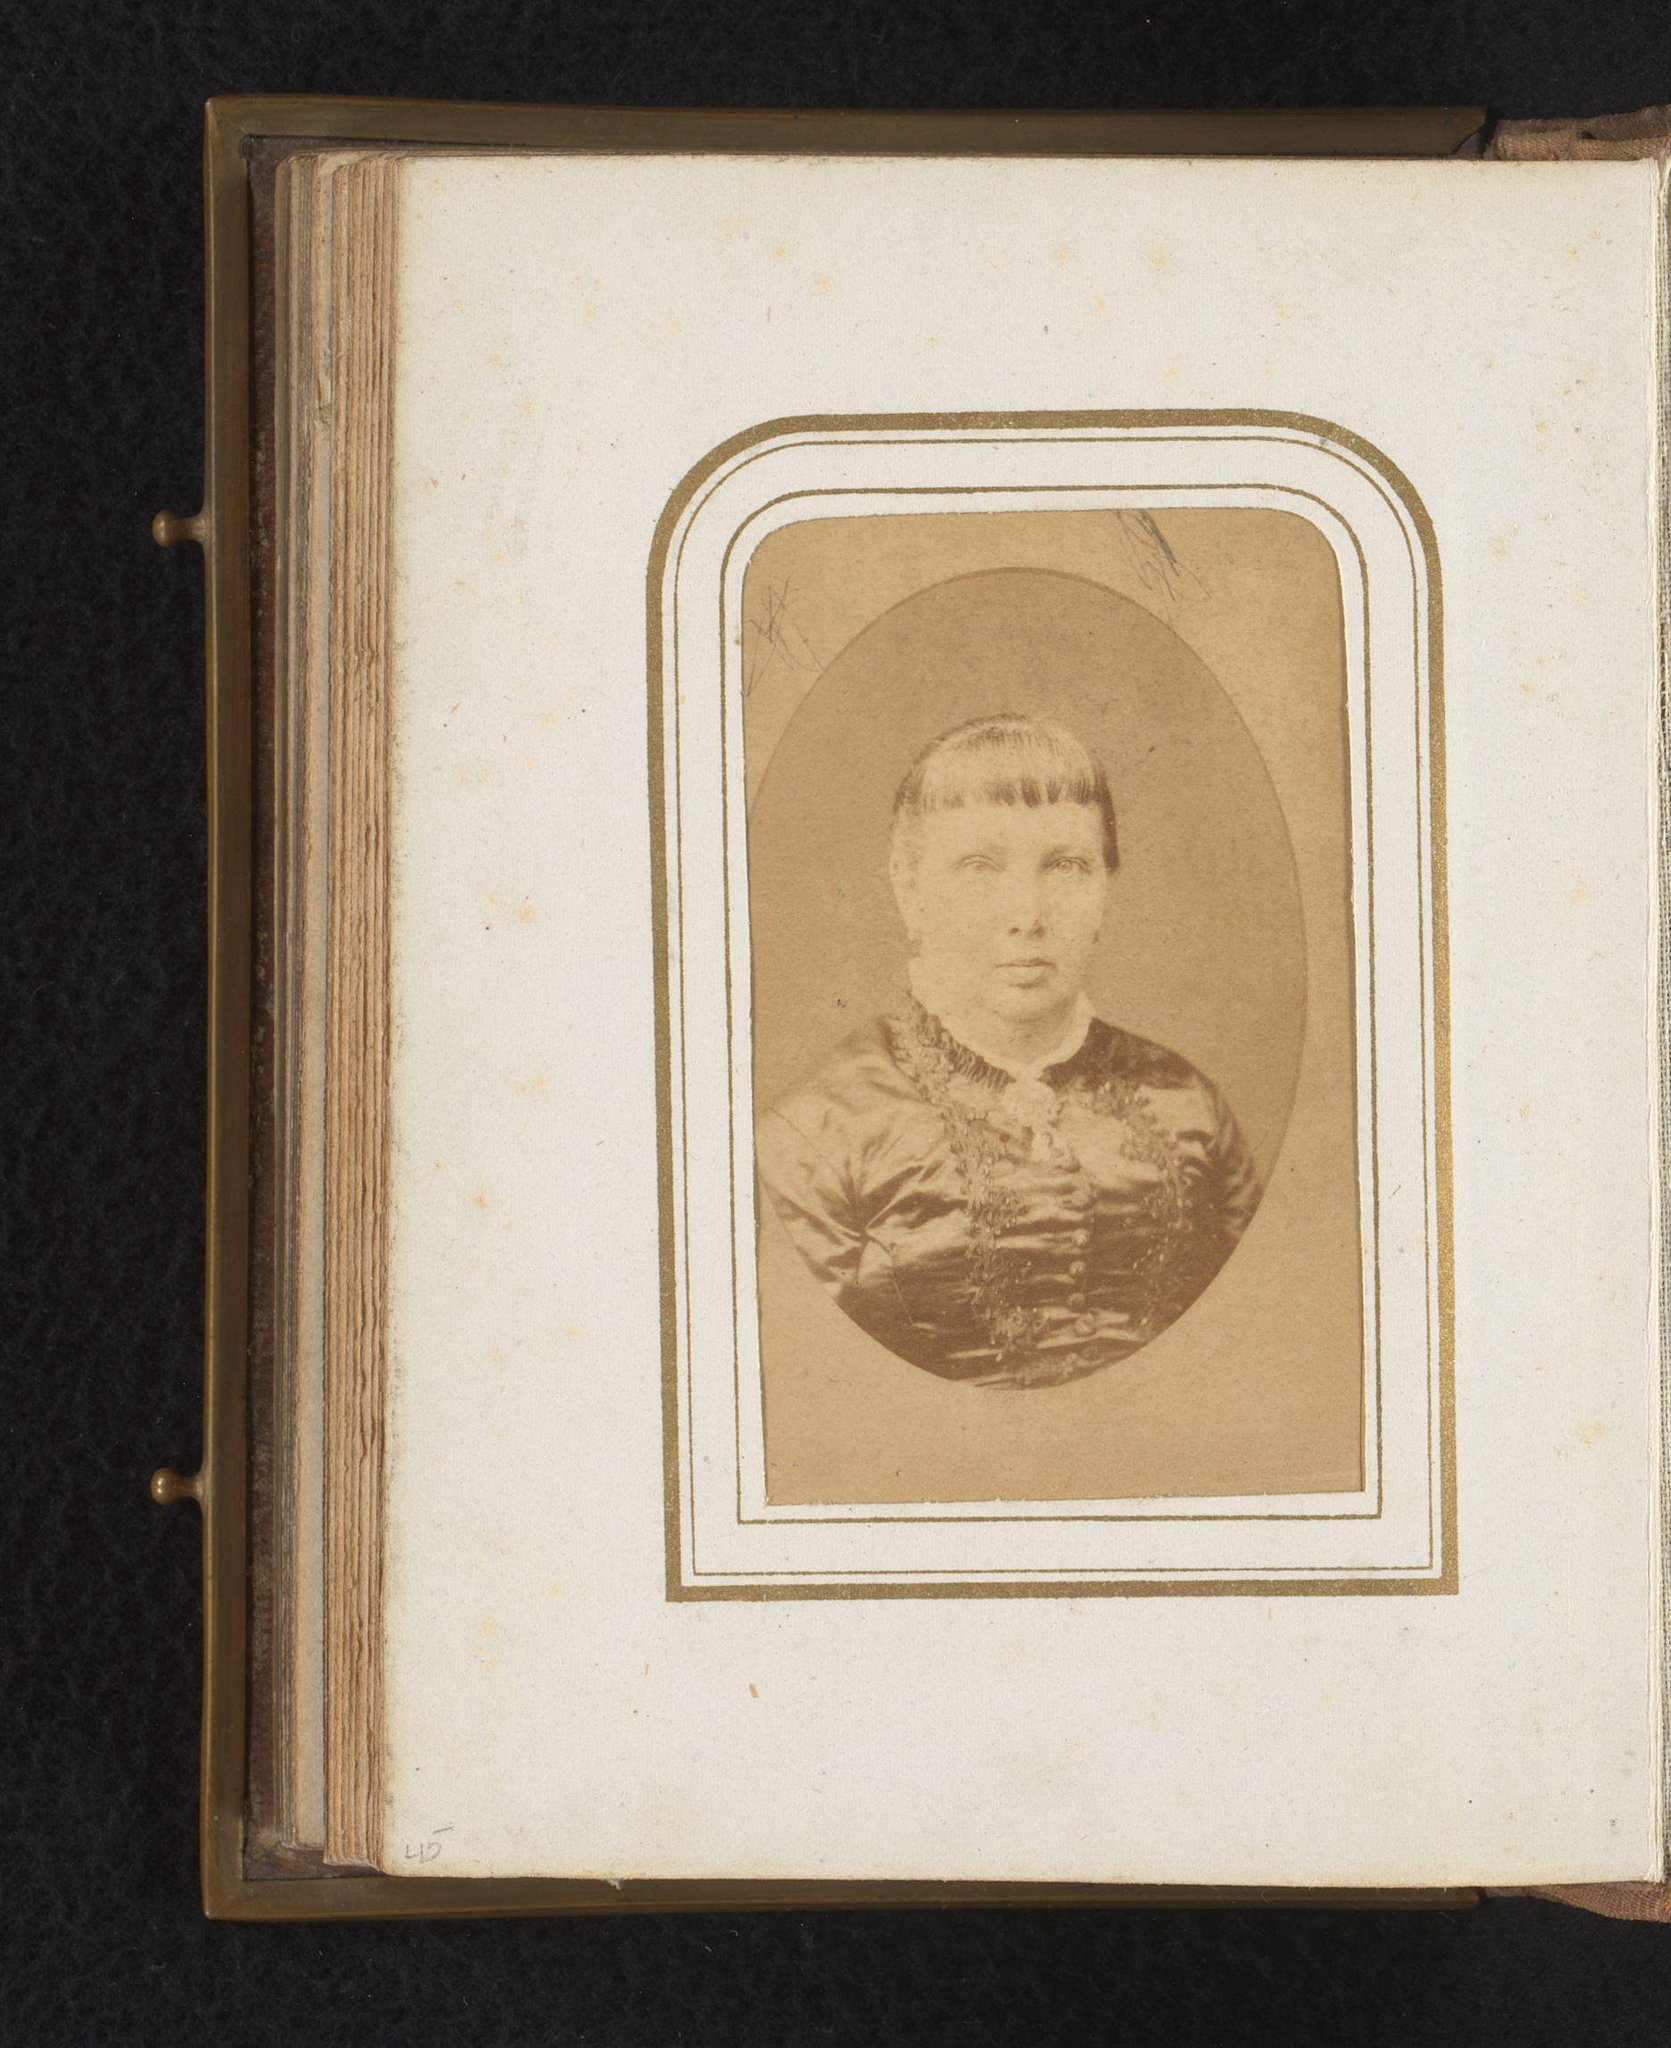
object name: photograph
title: Portret van een man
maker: Anonymous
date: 1860-1900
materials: cardboard, photographic support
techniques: albumen print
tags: adult woman, historical persons